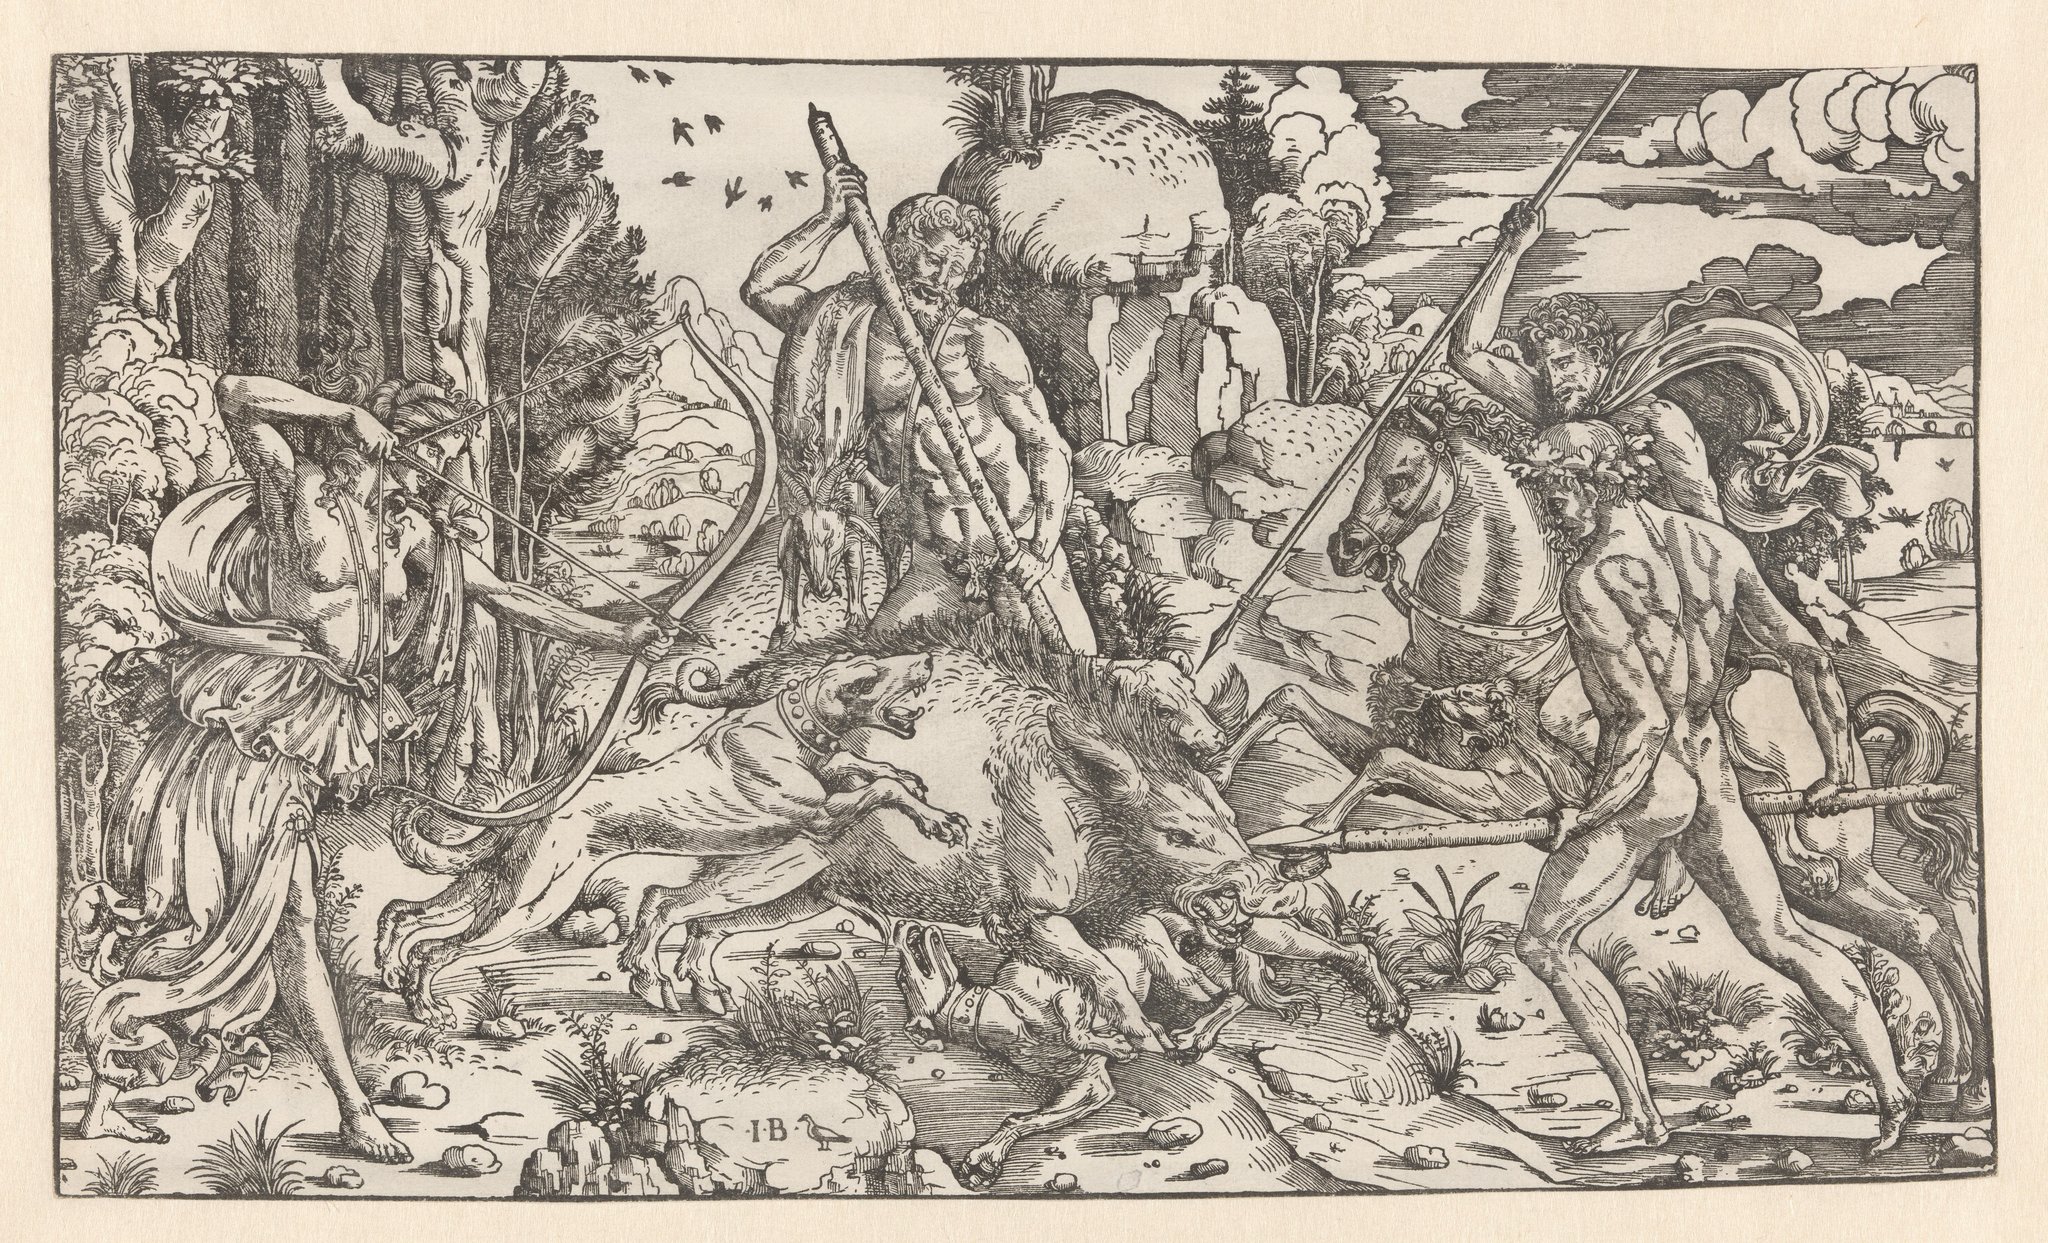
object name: print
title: The Calydonian Boar-Hunt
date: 1502-1511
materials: ink, paper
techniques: woodcut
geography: italy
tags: the calydonian hunt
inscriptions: collector's mark: Lugt 2228, collector's mark: Lugt 2760